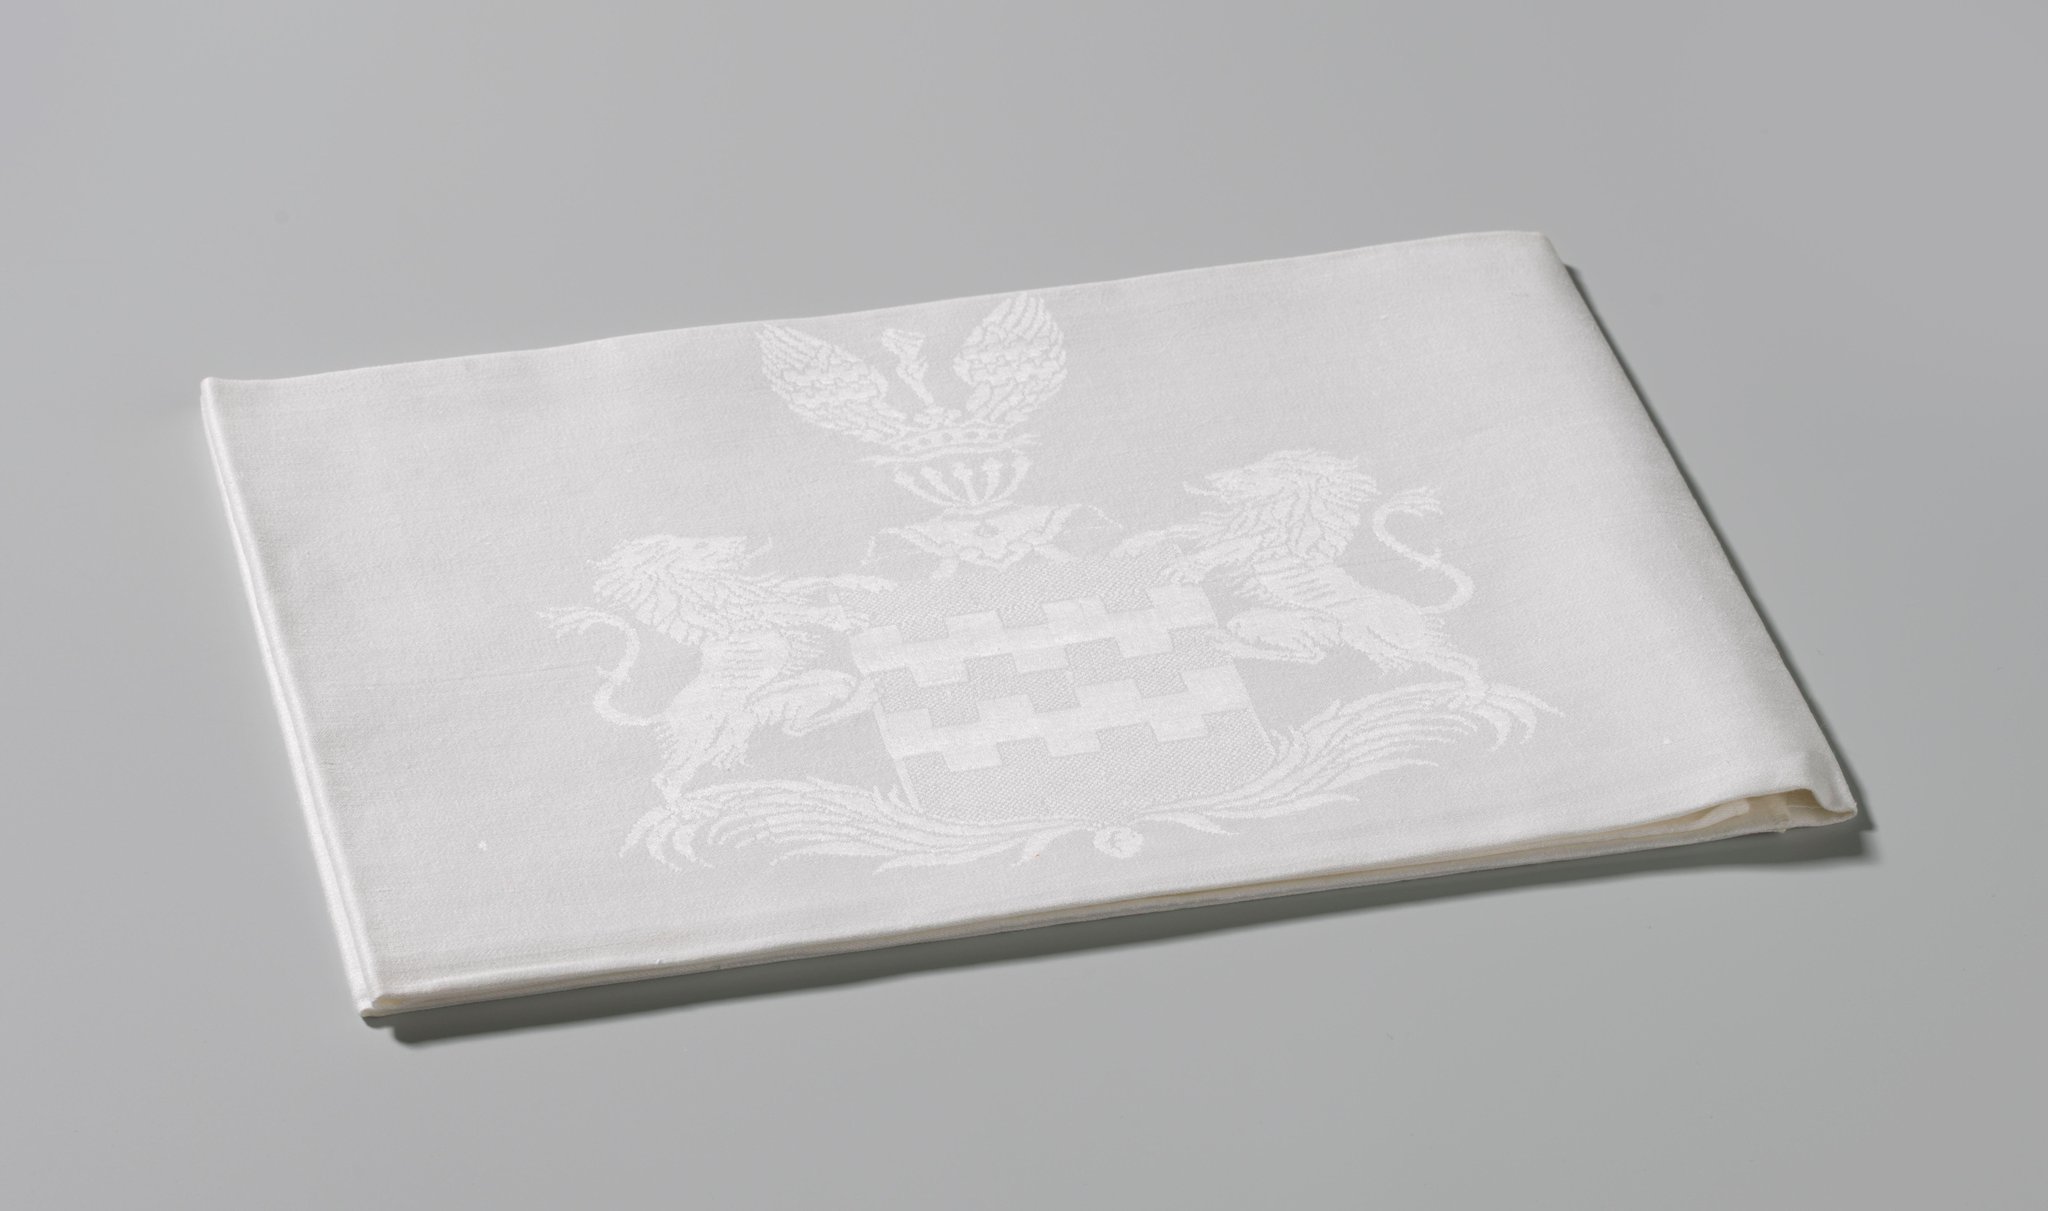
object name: napkin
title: Servet van wit linnendamast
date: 1874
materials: linen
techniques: damask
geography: north brabant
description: Wit linnen damasten servet met voluten en het wapen Van Boelens van der Haer.